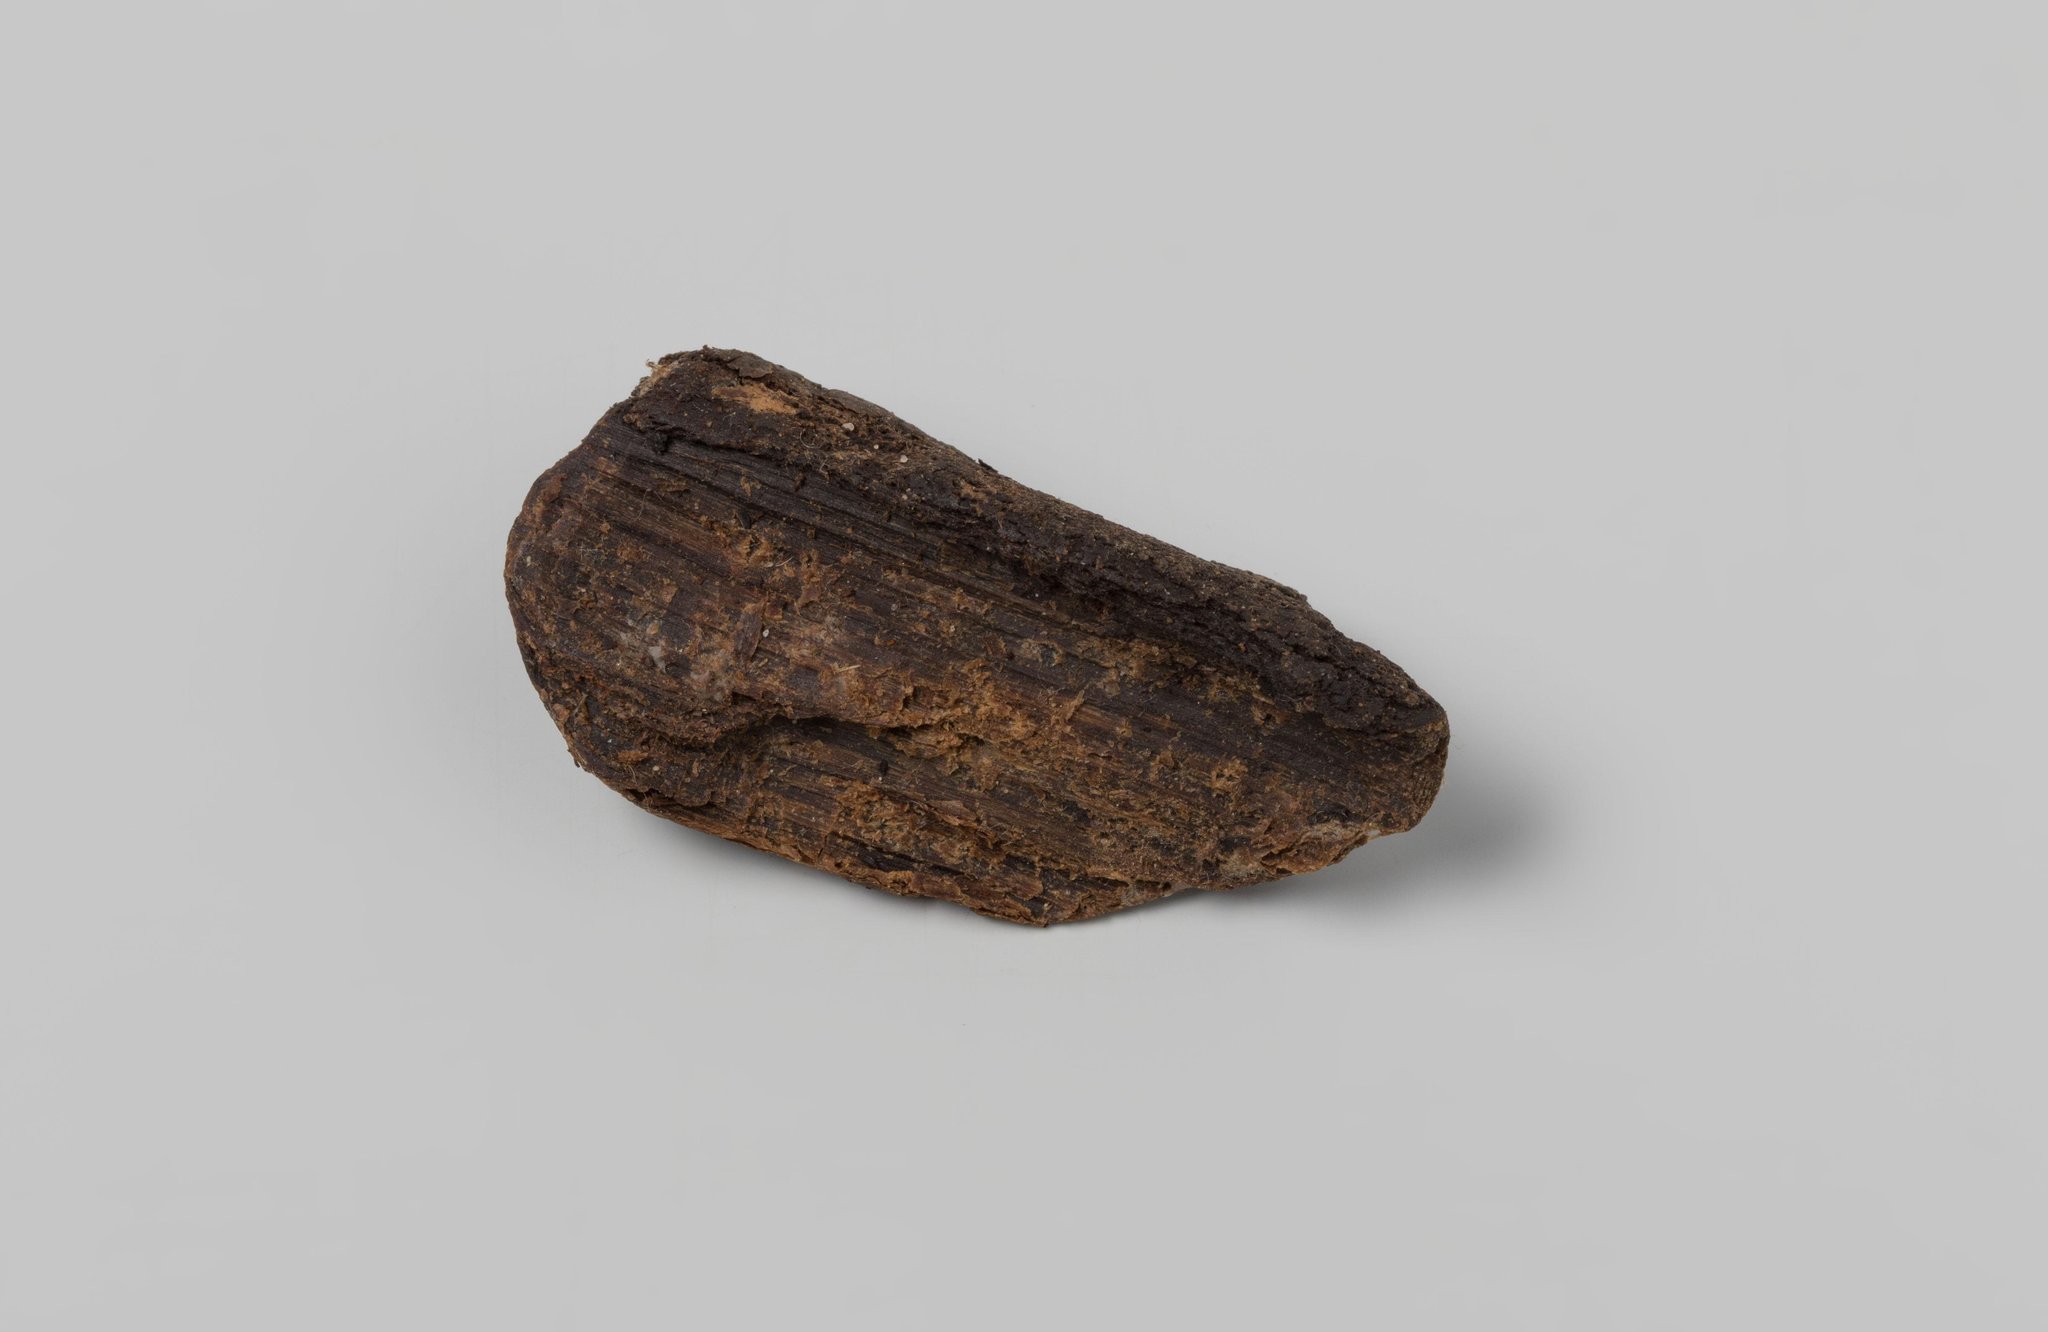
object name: fragment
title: Fragment hout uit het wrak van de Oost-Indiëvaarder Hollandia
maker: Anonymous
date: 1700-1743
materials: wood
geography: netherlands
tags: verenigde oostindische compagnie, hollandia (schip), annet